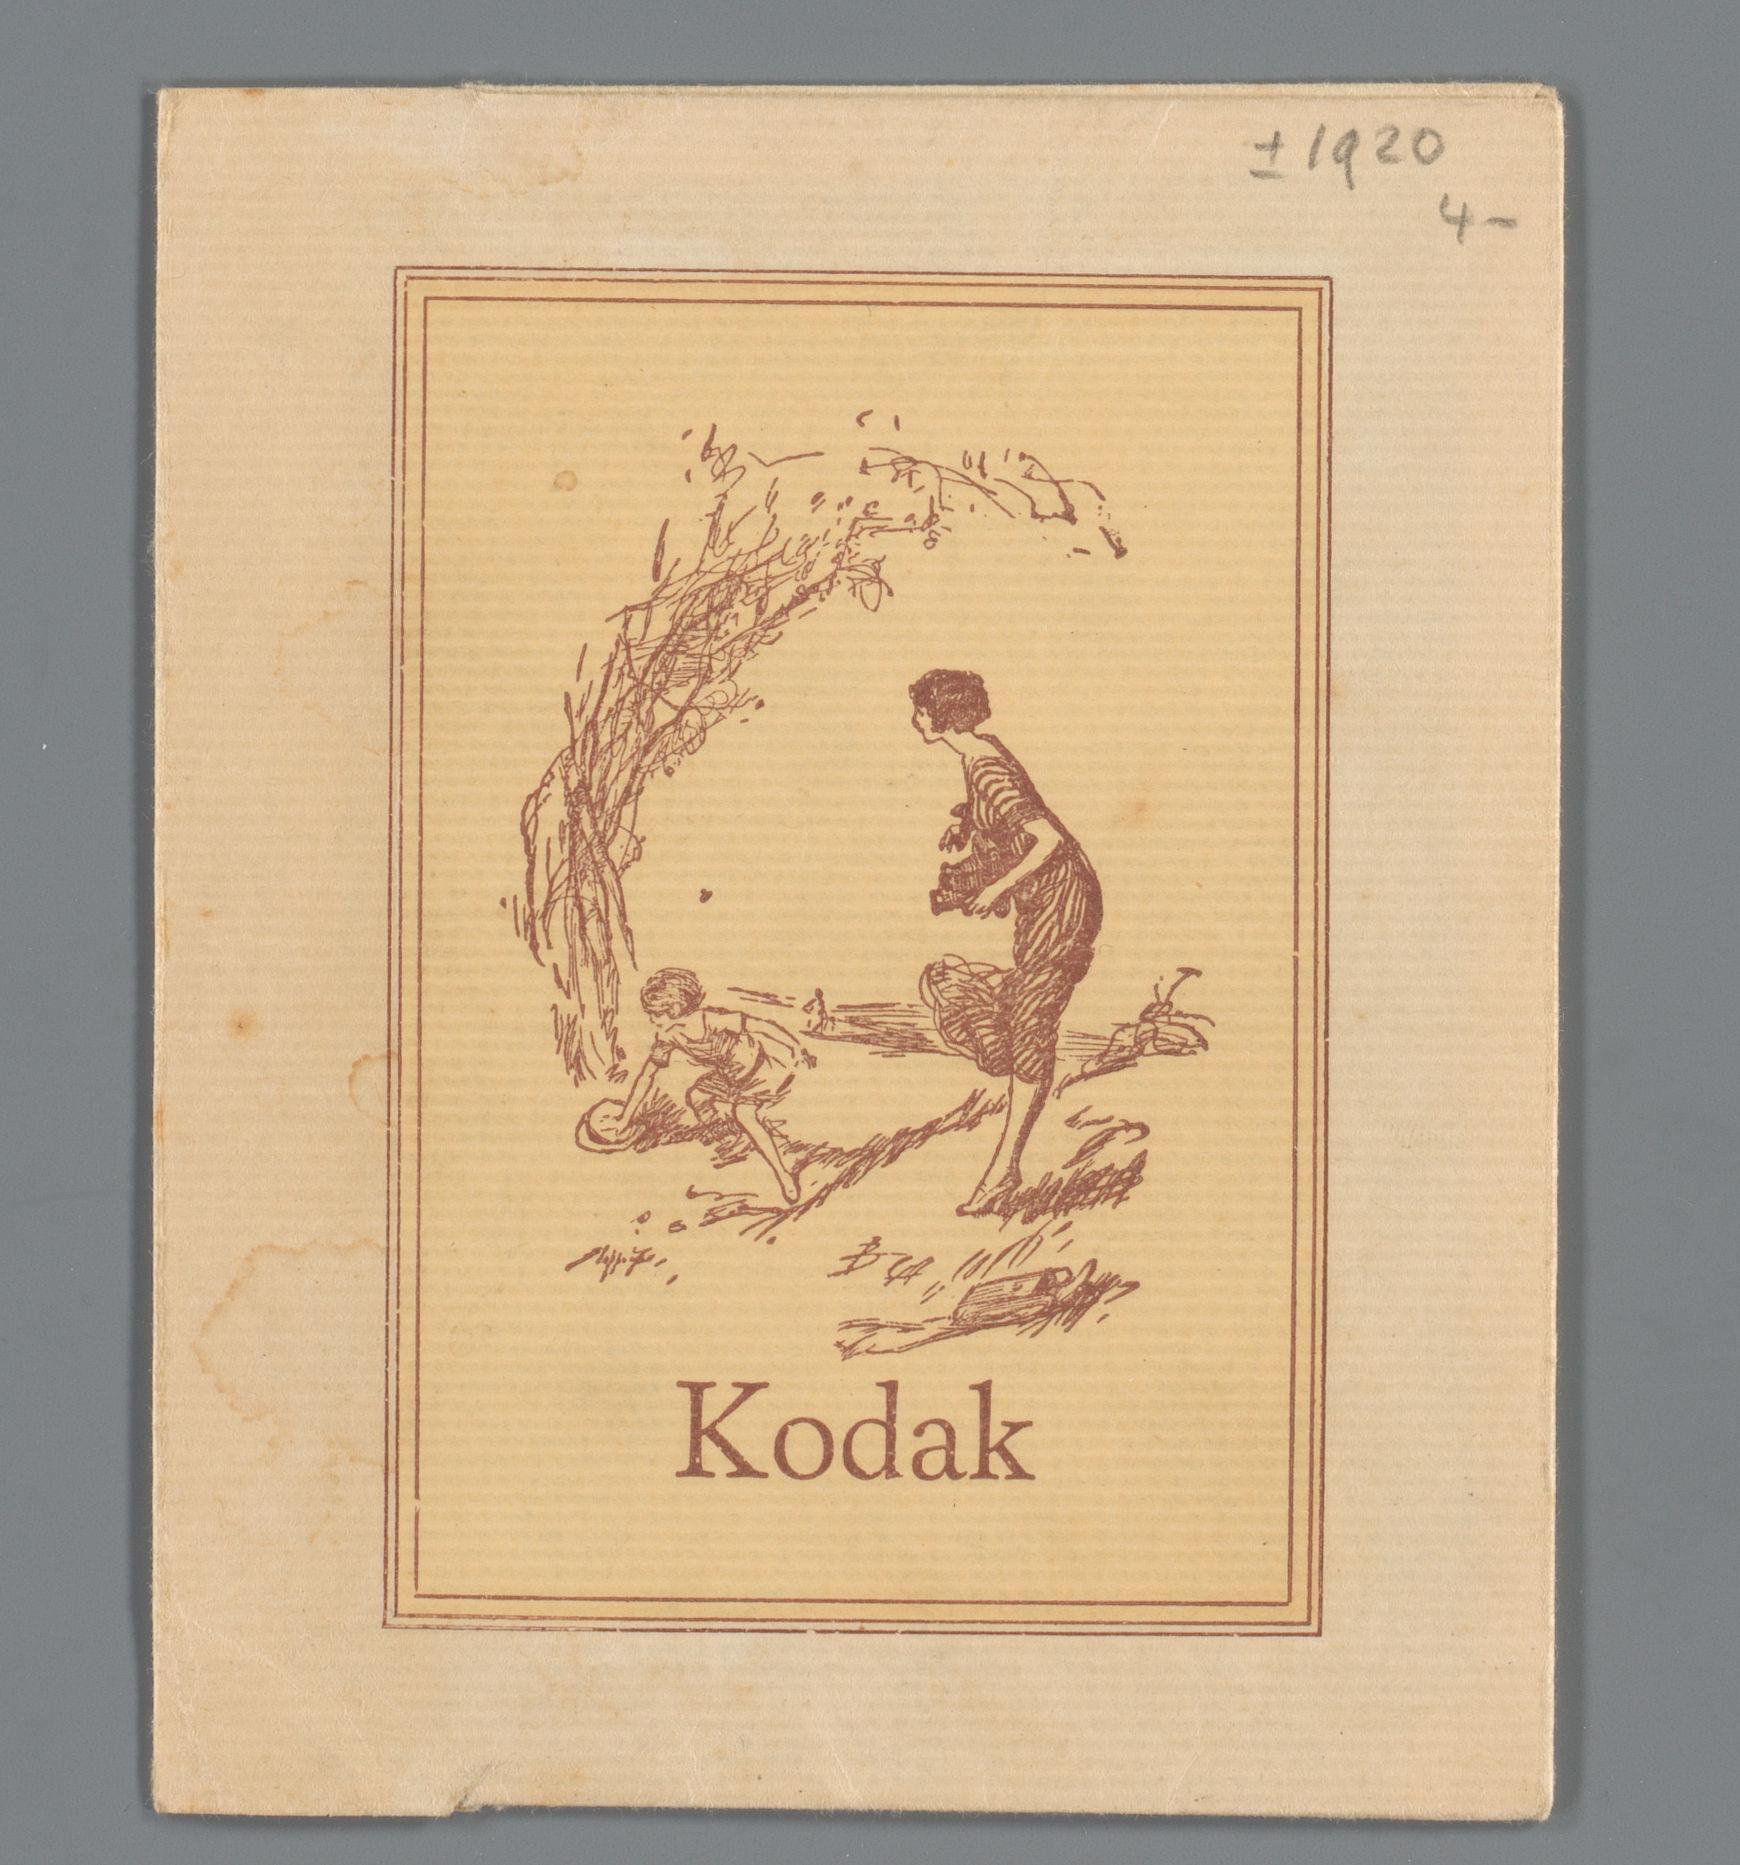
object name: filmnegatief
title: Omslag voor Kodak-negatieven met vier nitraatnegatieven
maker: Anonymous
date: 1920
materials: film, paper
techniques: gelatin silver negative, printing block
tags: parts of ship's exterior, historical persons, automobile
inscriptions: date: ‘+/- 1920/ 4-’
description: Omslag voor Kodak-negatieven, op de binnenzijde reclame voor vergrotingen en de Kodak-portretlens. In de envelop zitten vier nitraatnegatieven met daarop afgebeeld verschillende mensen bij een auto en een gezelschap aan boord van een schip.